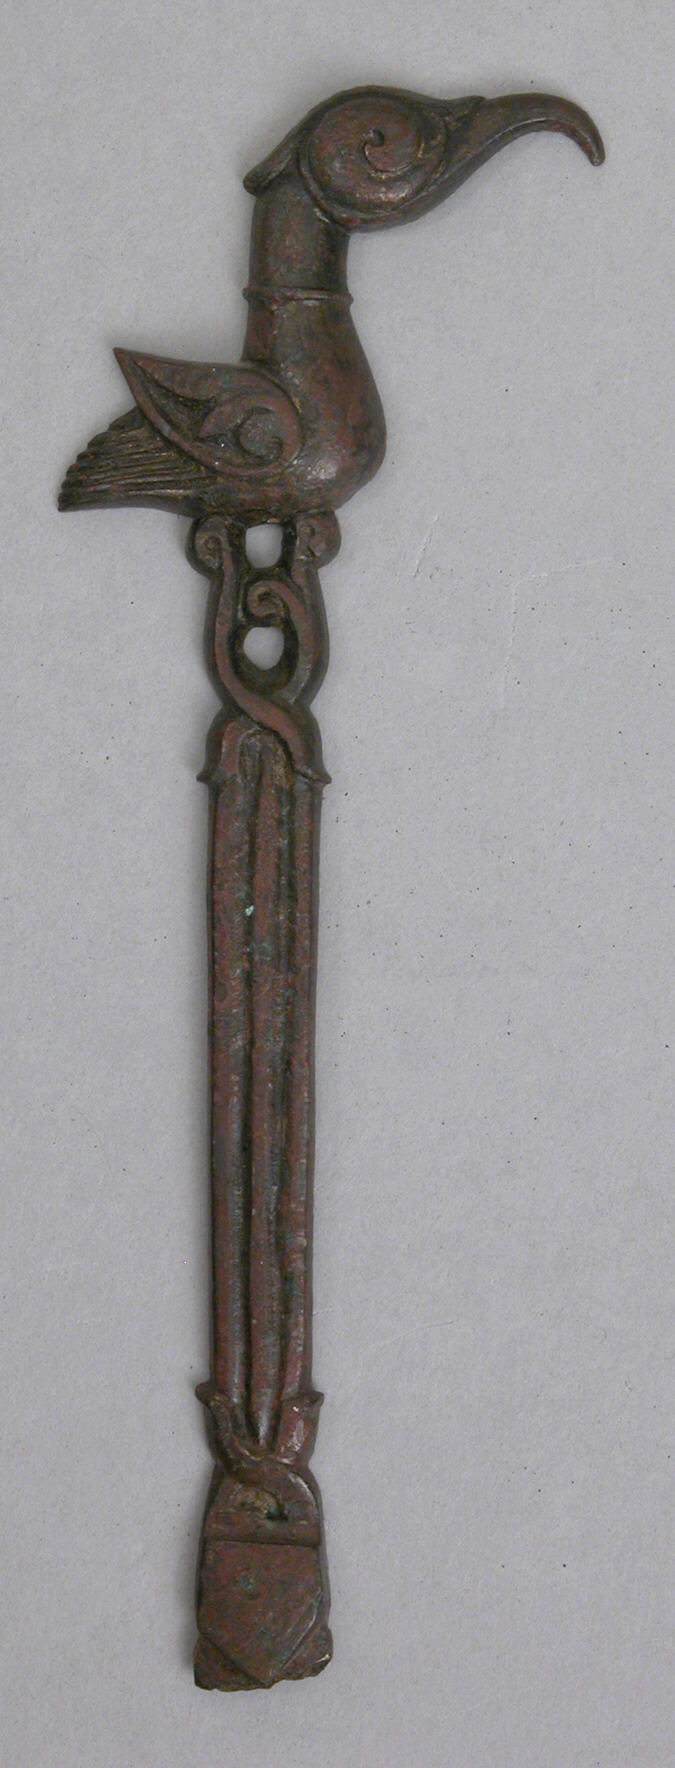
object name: finial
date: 1101-1200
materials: bronze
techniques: casting, engraving, gilding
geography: iran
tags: birds